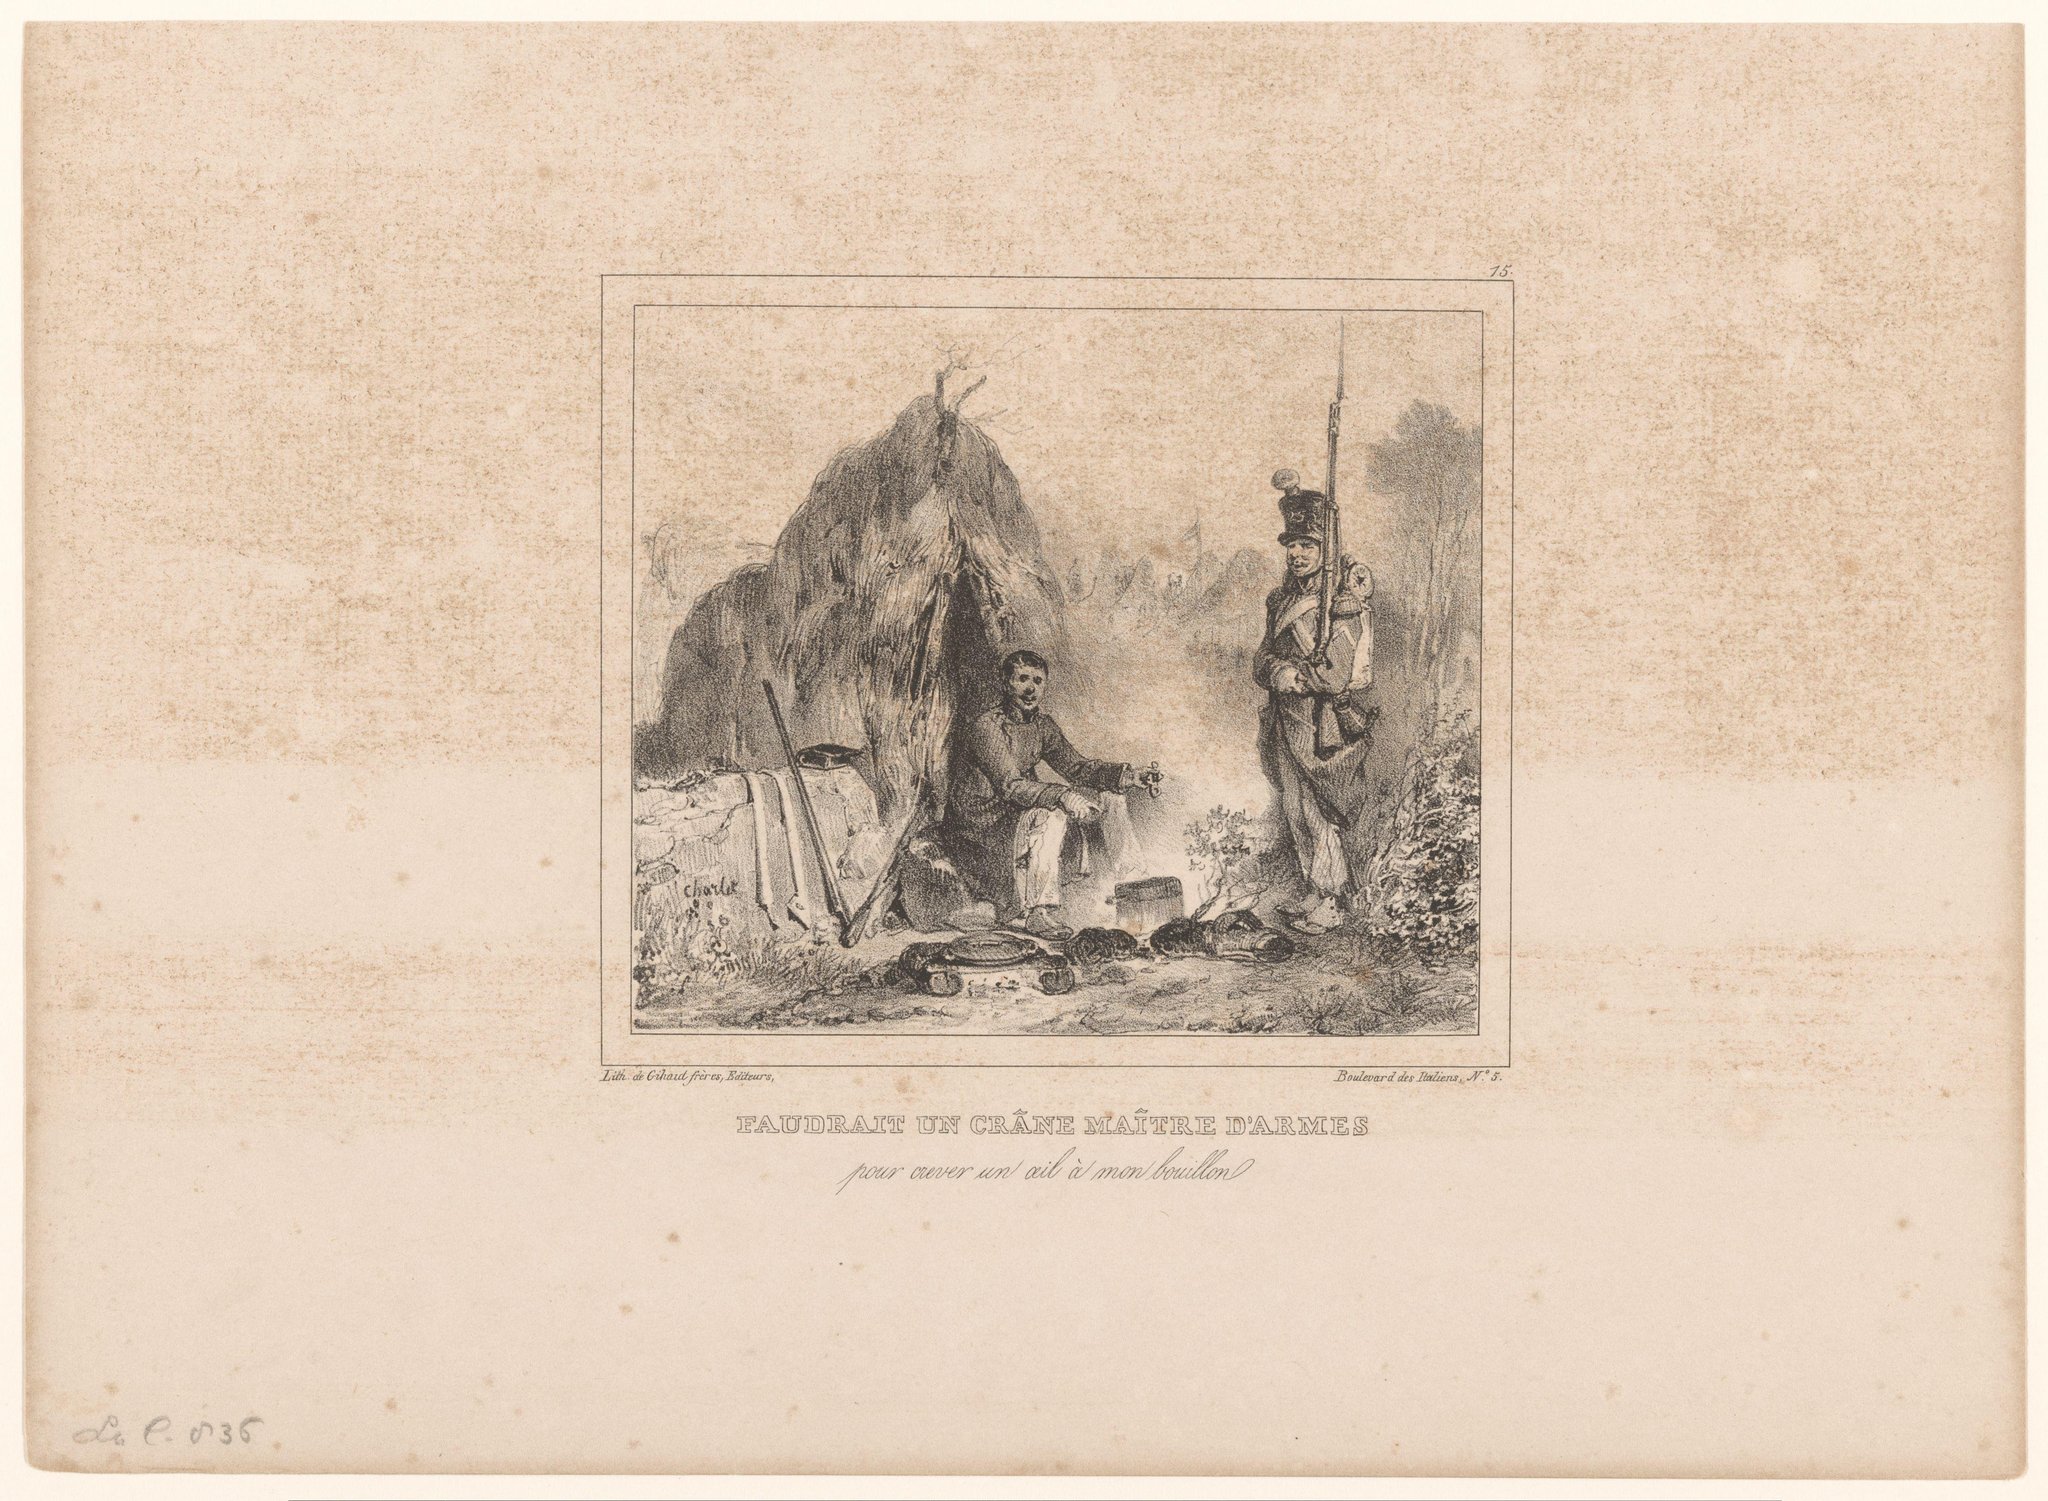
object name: print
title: Faudrait un crâne maître d'armes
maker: nicolas toussaint charlet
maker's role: draughtsman, painter, print maker, printer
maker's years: 1792-1845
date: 1834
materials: paper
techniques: lithograph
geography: paris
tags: (military) camp with tents, cooking food - cc - in the open air, broth, soup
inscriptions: collector's mark: Lugt 2228a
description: De soldaat zegt grappend dat hij een schedel nodig heeft om een ei te kunnen laten barsten voor zijn soep.